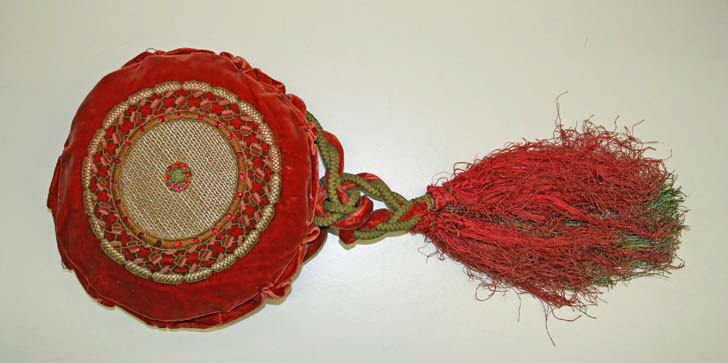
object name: hat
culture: american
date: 1868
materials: silk